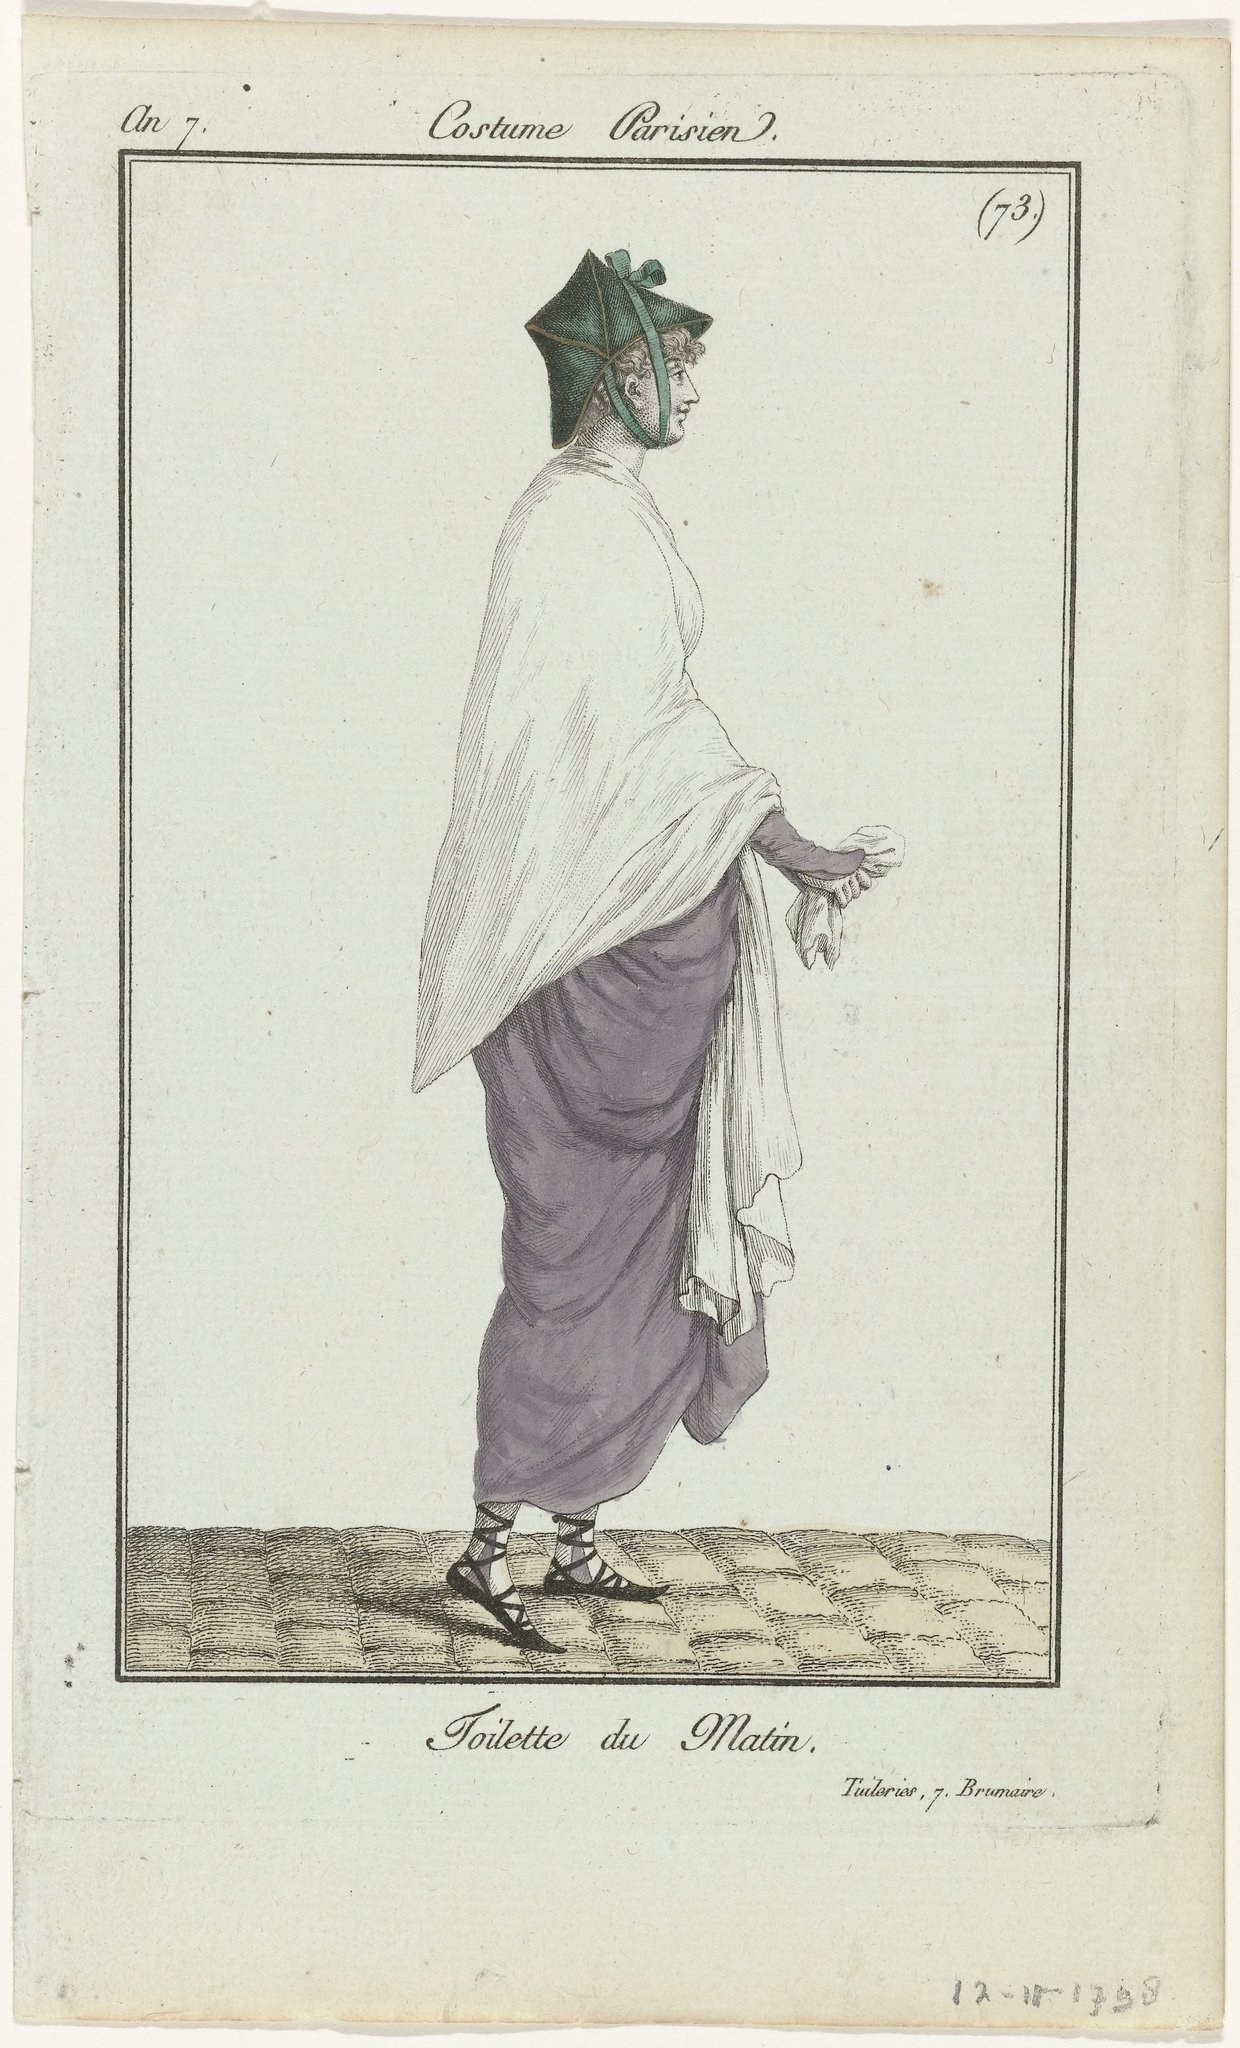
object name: fashion print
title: Journal des Dames et des Modes, Costume Parisien, 18 novembre 1798, An 7, (73.) : Toilette du Matin.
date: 1798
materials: paper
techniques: engraving, hand coloring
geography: paris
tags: handkerchief (+ women's clothes), clothing for the upper part of the body (shawl) (+ women's clothes), head-gear (+ women's clothes), fashion plates, shoes, sandals (+ women's clothes), dress, gown (+ women's clothes), stockings, socks (+ women's clothes)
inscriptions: caption: ‘Toilette du Matin. / Tuileries, 7. Brumaire.’, title: ‘Costume Parisien.’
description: Vrouw, lopend naar rechts, op de rug gezien, gekleed in een 'toilette' voor in de ochtend. Zij draagt een japon met lange mouwen. Grote sjaal om de schouders. Kousen met gekleurde klinken. Accessoires: hoed, zakdoek, platte schoenen met puntige neuzen en gekruiste banden. Volgens het onderschrift is deze voorstelling naar het leven getekend in de 'Tuileries, 7. Brumaire'. De prent maakt deel uit van het modetijdschrift Journal des Dames et des Modes, uitgegeven door Sellèque, Parijs, 1797-1839.